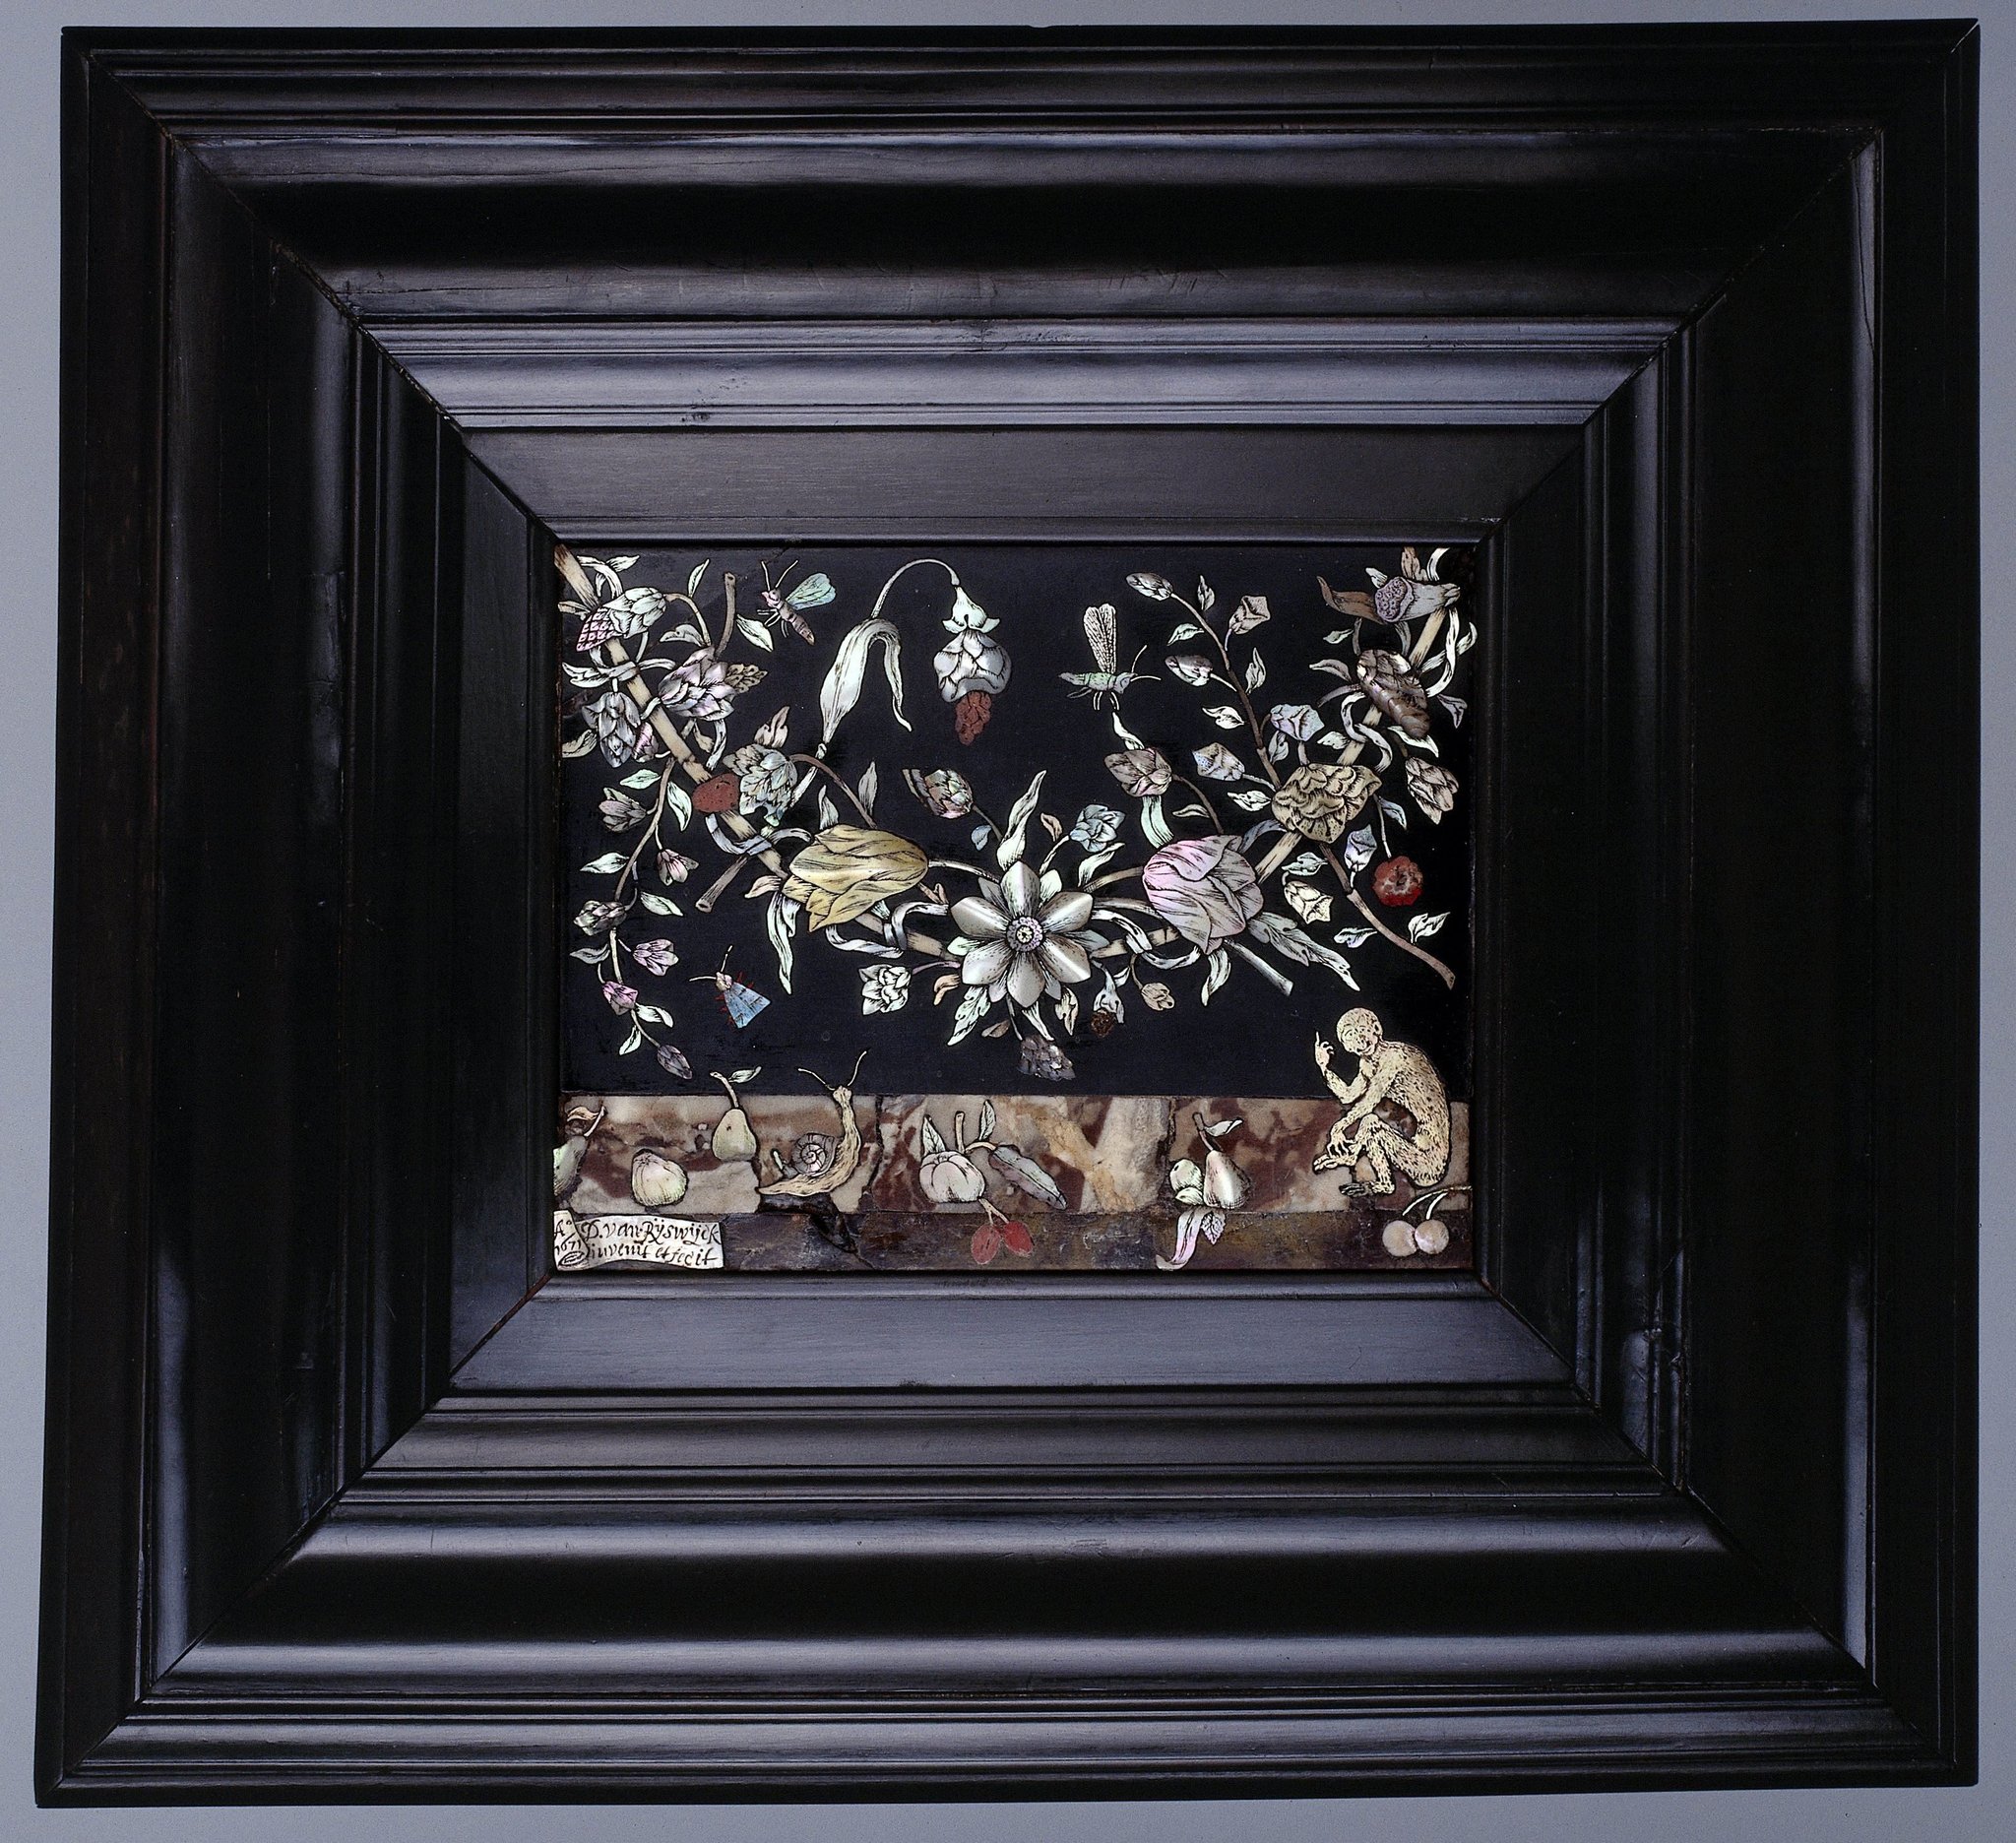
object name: panel ornament area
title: Paneel met ingelegde voorstelling van een tafelblad met aap, slak en vruchten onder een bloemenslinger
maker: dirk van rijswijck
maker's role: medailleur, paarlemoerinlegger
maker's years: 1596-1679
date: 1671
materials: marble, mother of pearl, stone, wood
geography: amsterdam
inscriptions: signature and date: ‘D.Van.Rijswijck // invenit et fecit // Ao 1671’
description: Panel. Touchstone, inlaid with mother-of-pearl, marble and ivory. Amsterdam, Dirck van Rijswijck, 1671. On loan from the Royal Antiquarian Society.